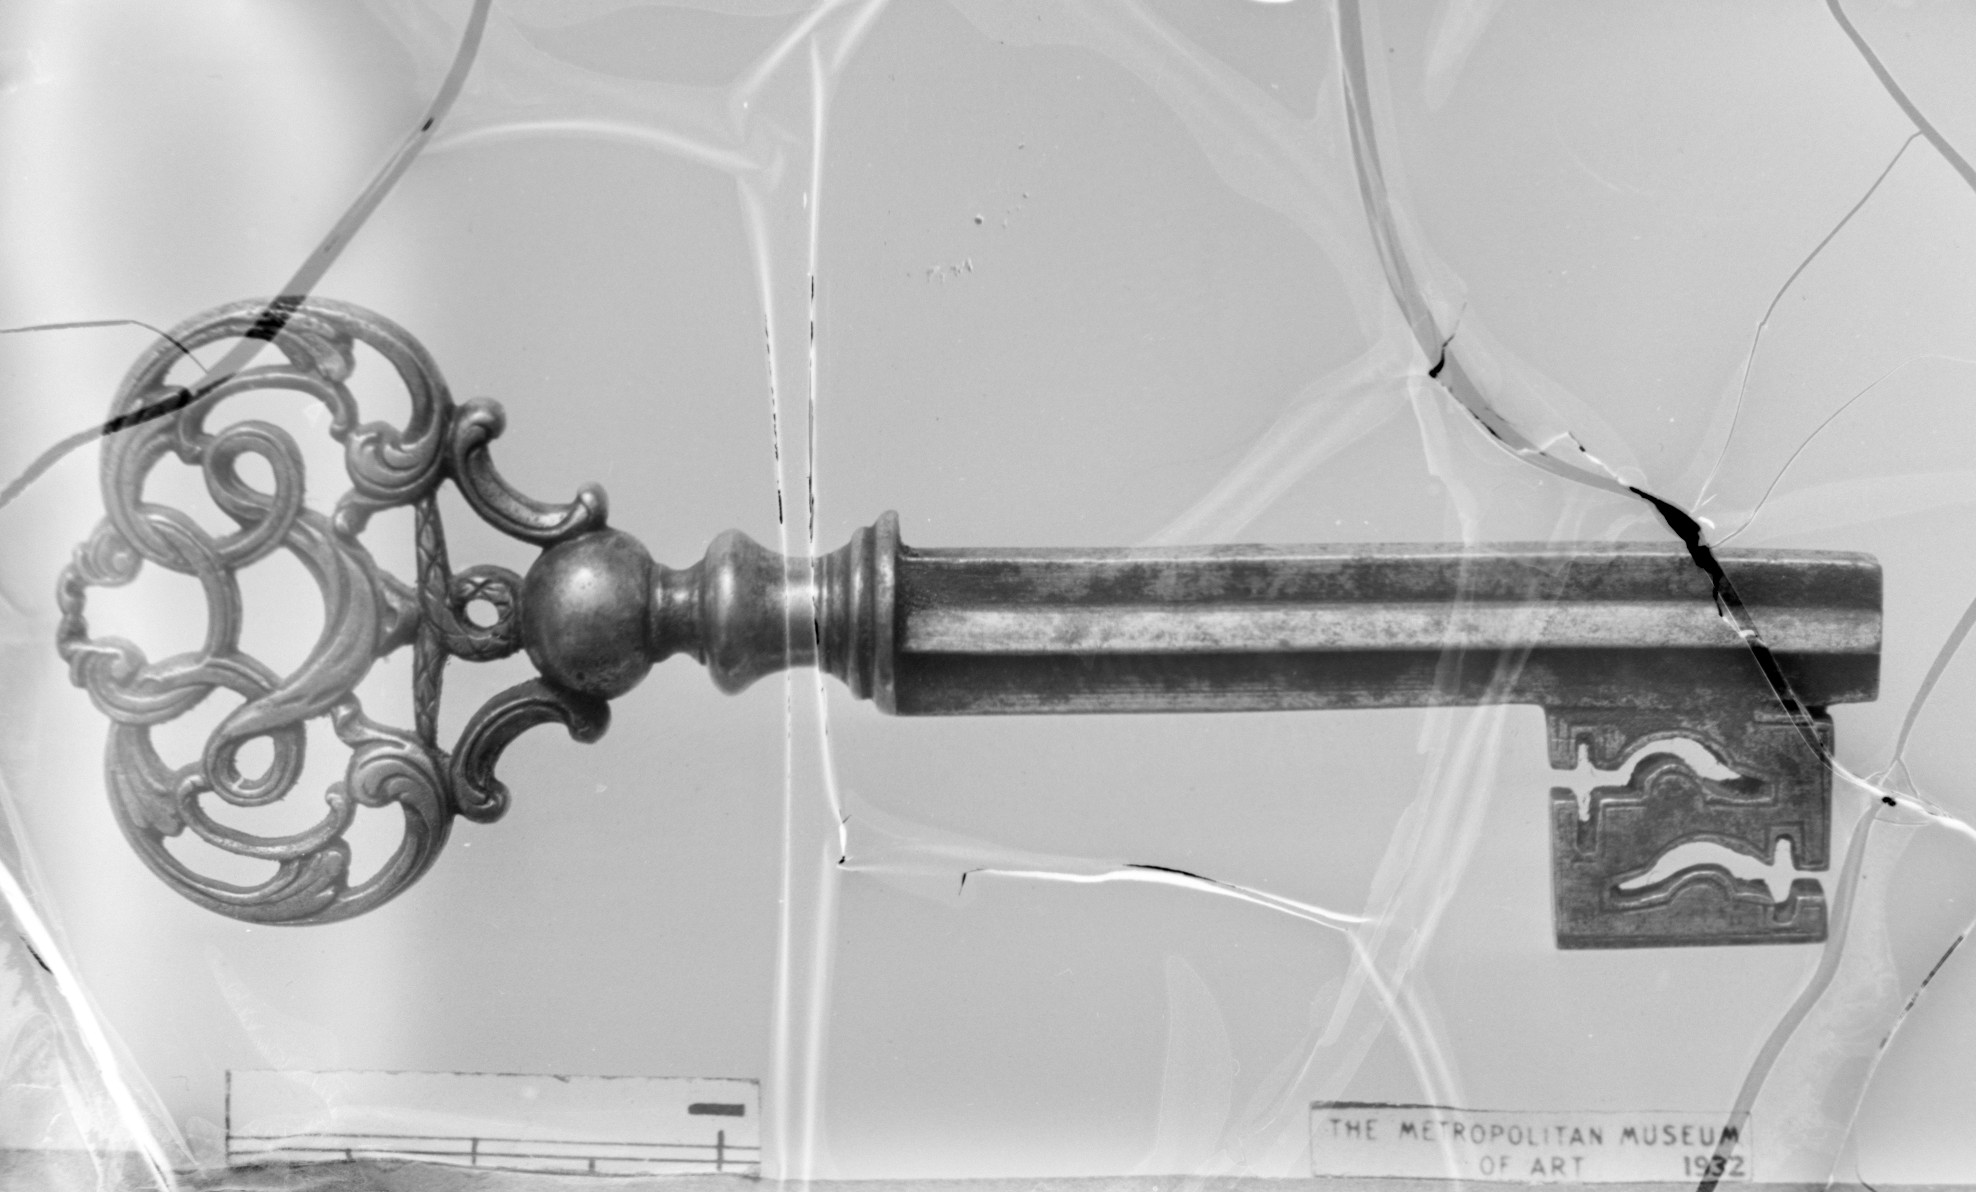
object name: key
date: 1601-1700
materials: iron